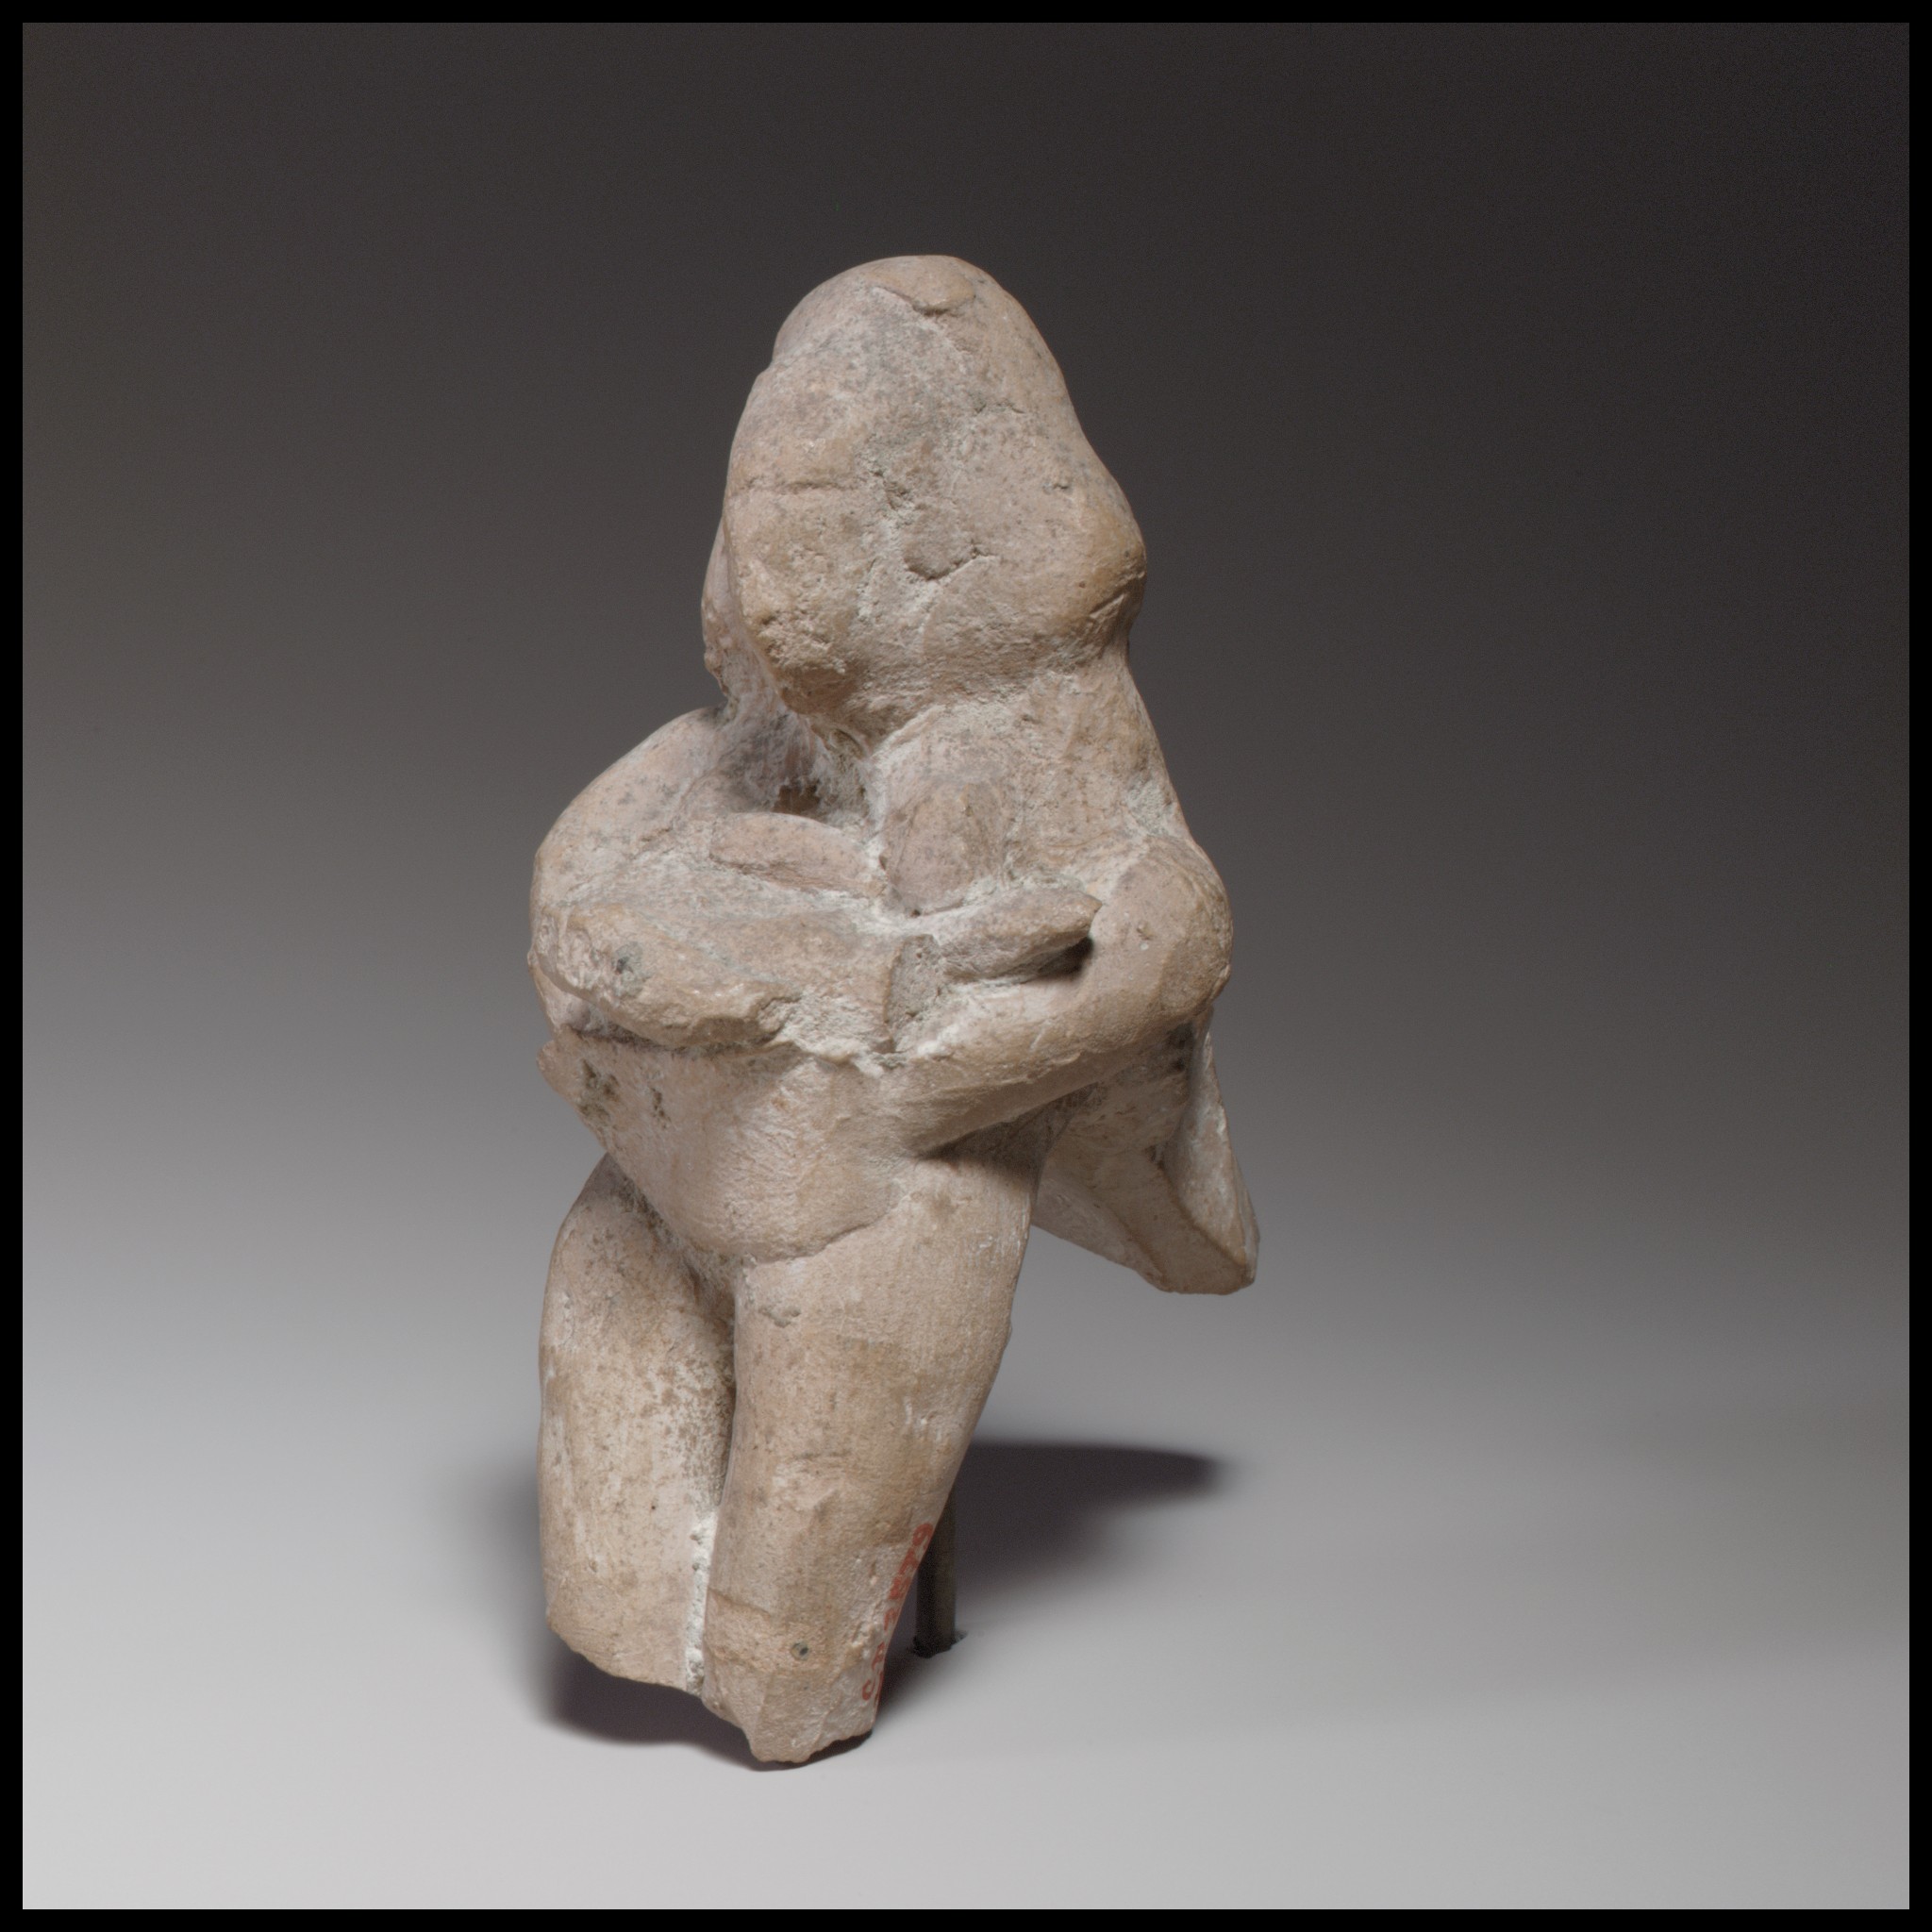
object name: statuette of a woman with bird face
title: Seated female figurine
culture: cypriot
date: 600-480 BCE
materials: terracotta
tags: women